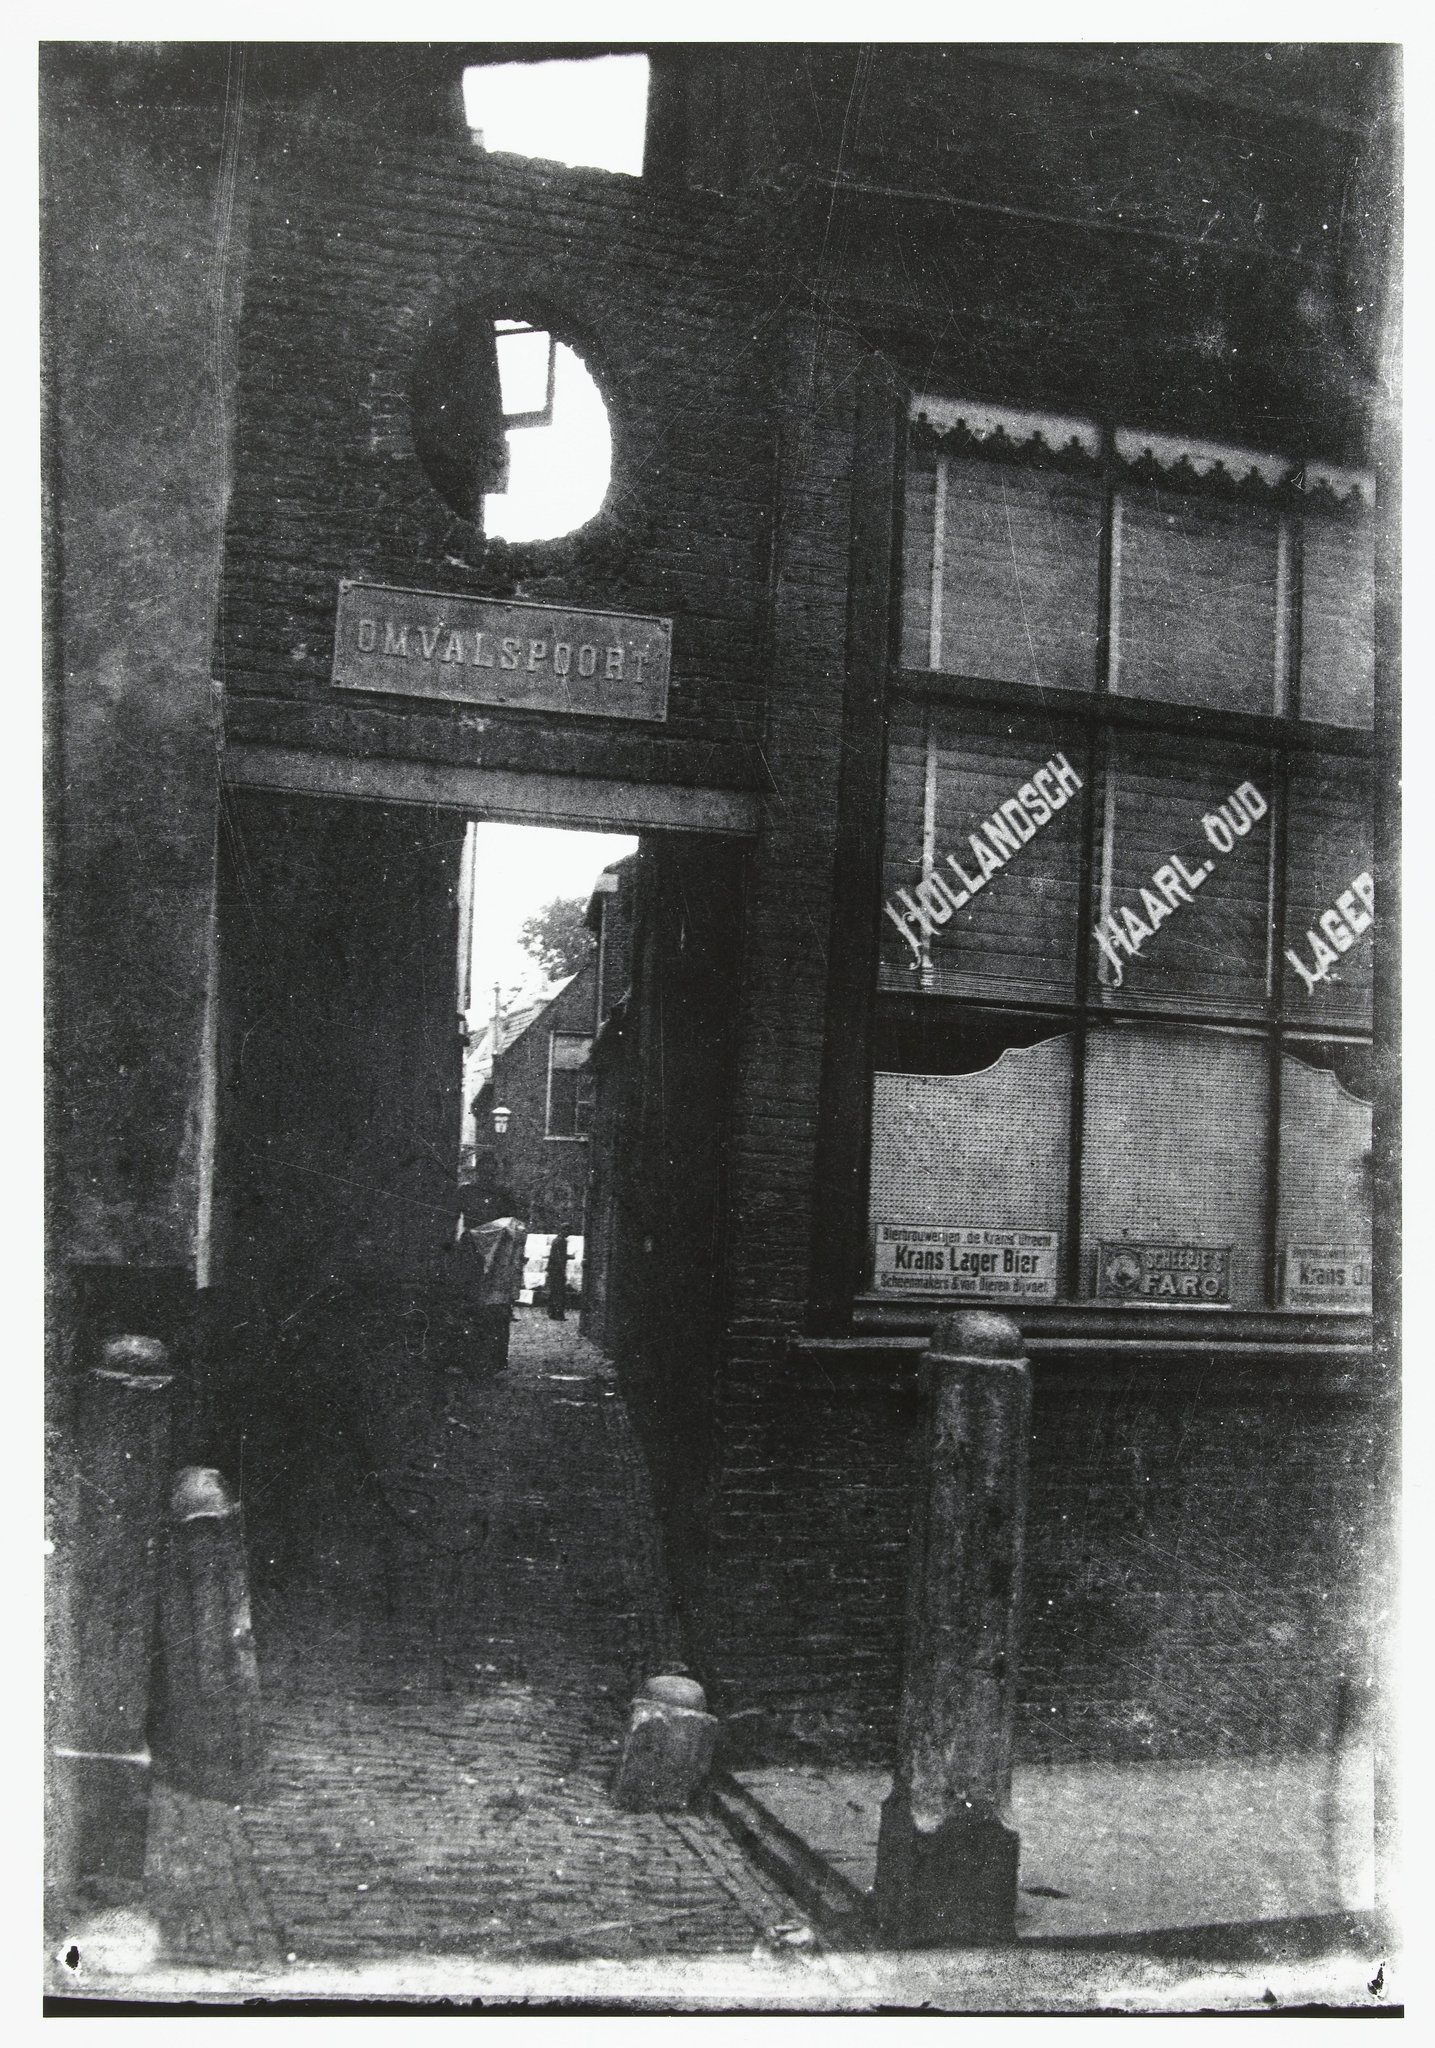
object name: photograph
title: Doorkijk door de Omvalspoort in Haarlem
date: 1890-1910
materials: paper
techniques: gelatin silver print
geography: amsterdam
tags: haarlem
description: Moderne afdruk van negatief BR 956 (collectie RKD).